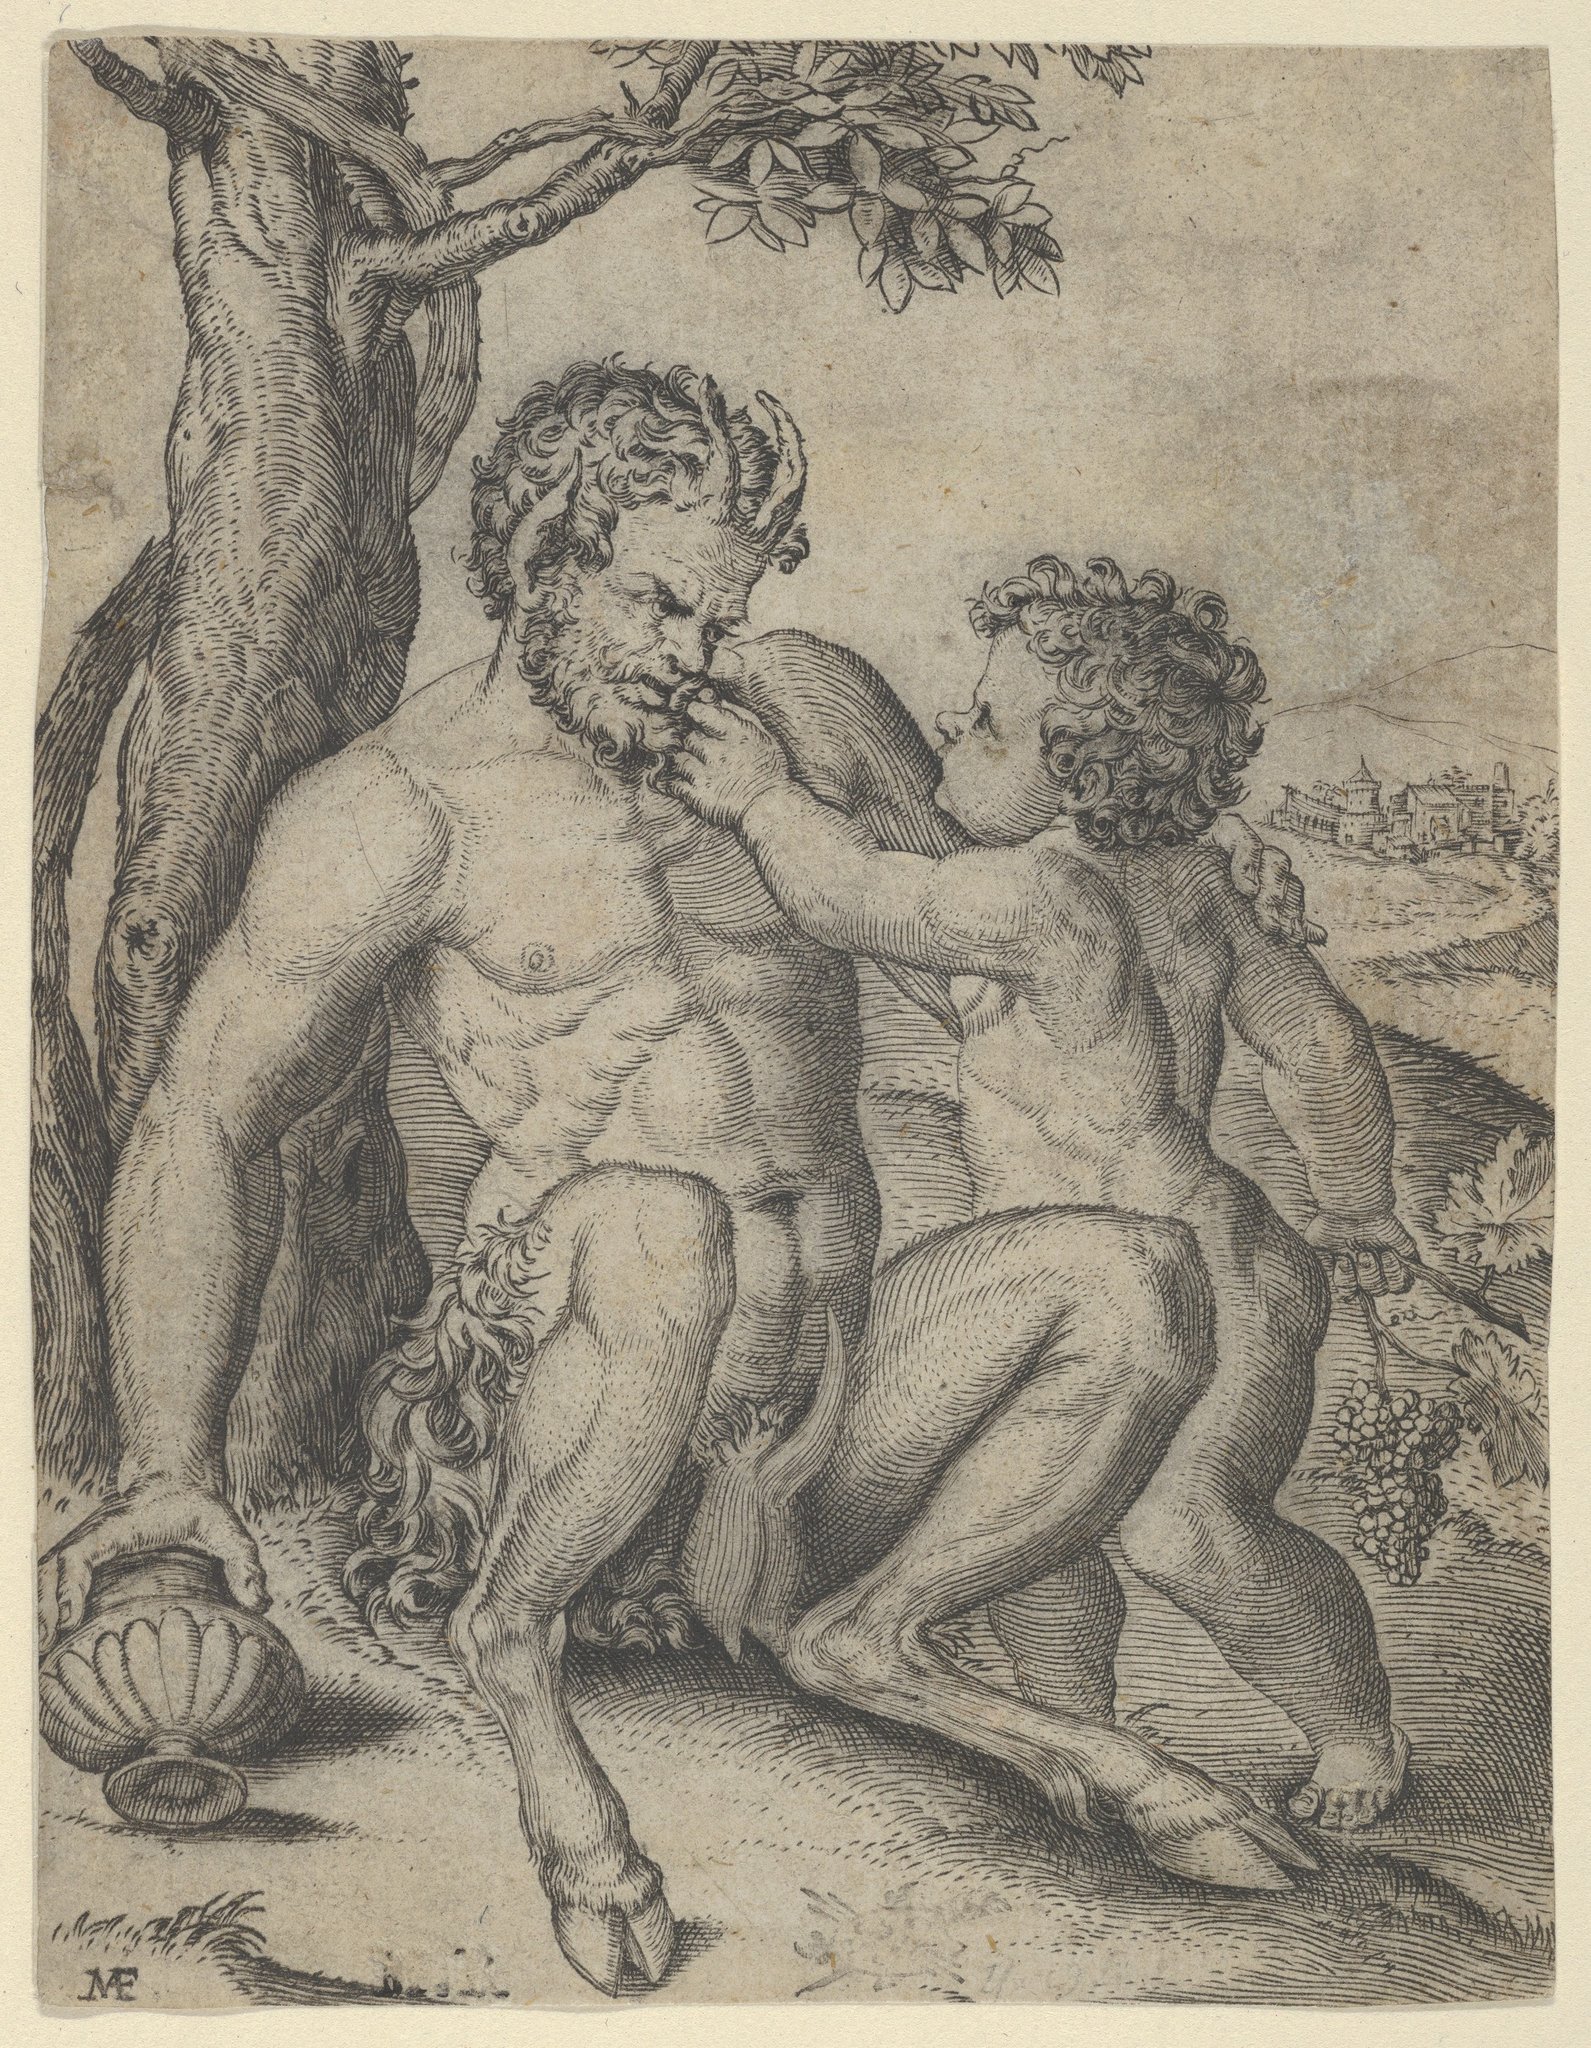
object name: print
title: Satyr and Child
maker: marcantonio raimondi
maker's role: artist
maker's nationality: italian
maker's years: 1475-1534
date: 1515-1516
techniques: engraving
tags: children,satyrs